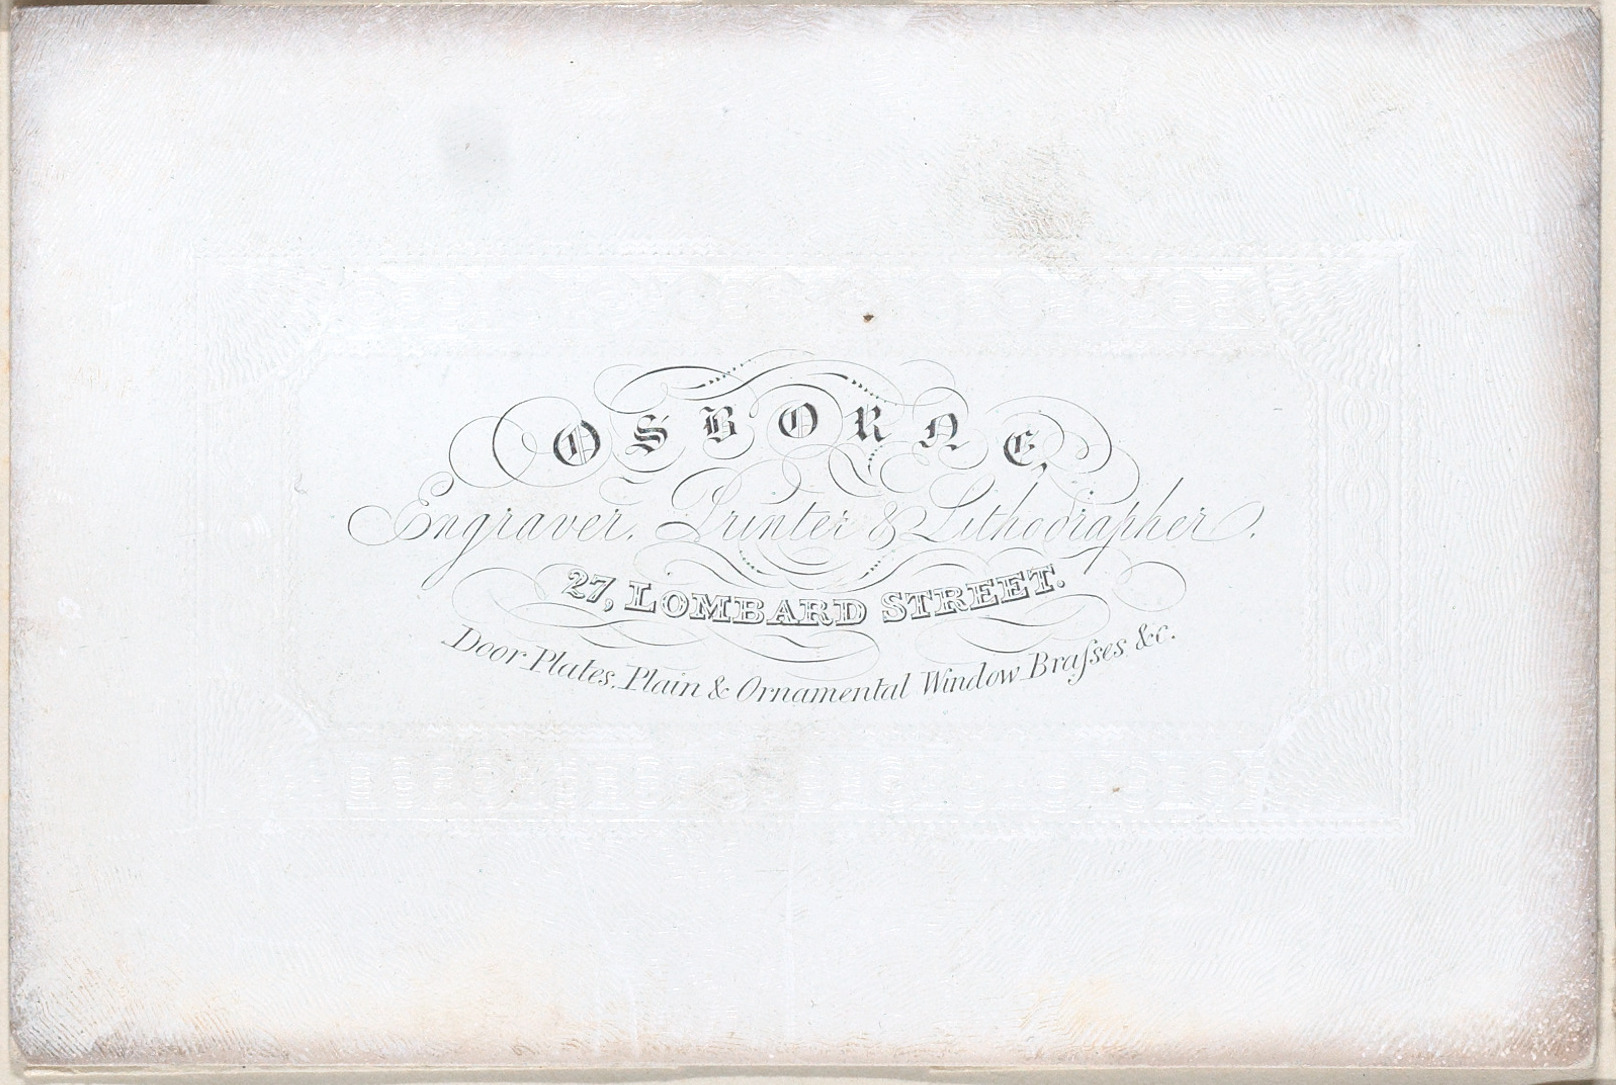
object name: print, trade card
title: Trade Card for Osborne, Engraver, Printer, and Lithographer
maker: anonymous, british, 19th century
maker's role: artist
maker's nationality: british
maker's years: 1800-1900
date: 1801-1900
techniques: engraving